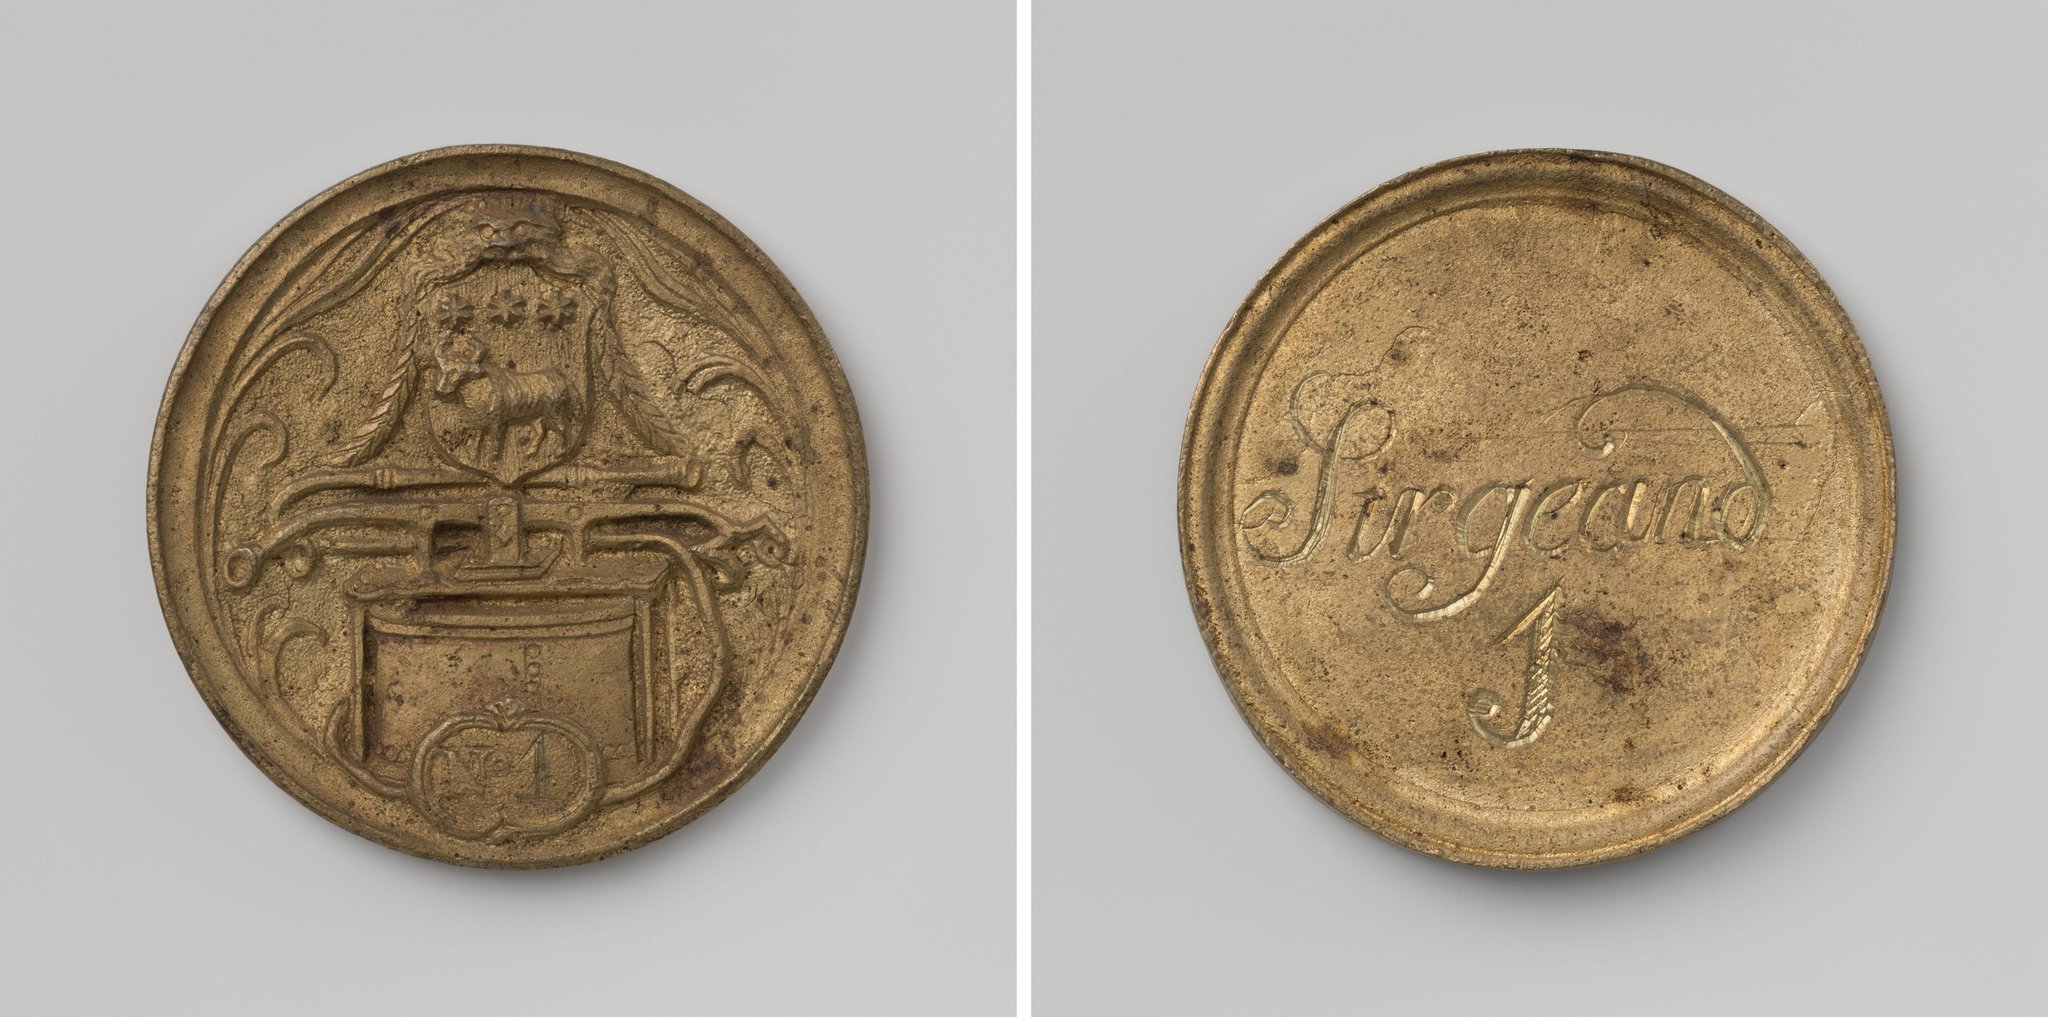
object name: fire engine medal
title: Edam, brandspuitpenning van sergeant no. 1 van spuit no. 1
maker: Anonymous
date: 1680-1800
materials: brass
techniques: casting, engraving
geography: edam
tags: edam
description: Messing penning. Voorzijde: wapenschild omhangen met guirlande boven brandspuit en cartouche met cijfer No. 2 omgeven door bladertakken. Keerzijde: opschrift